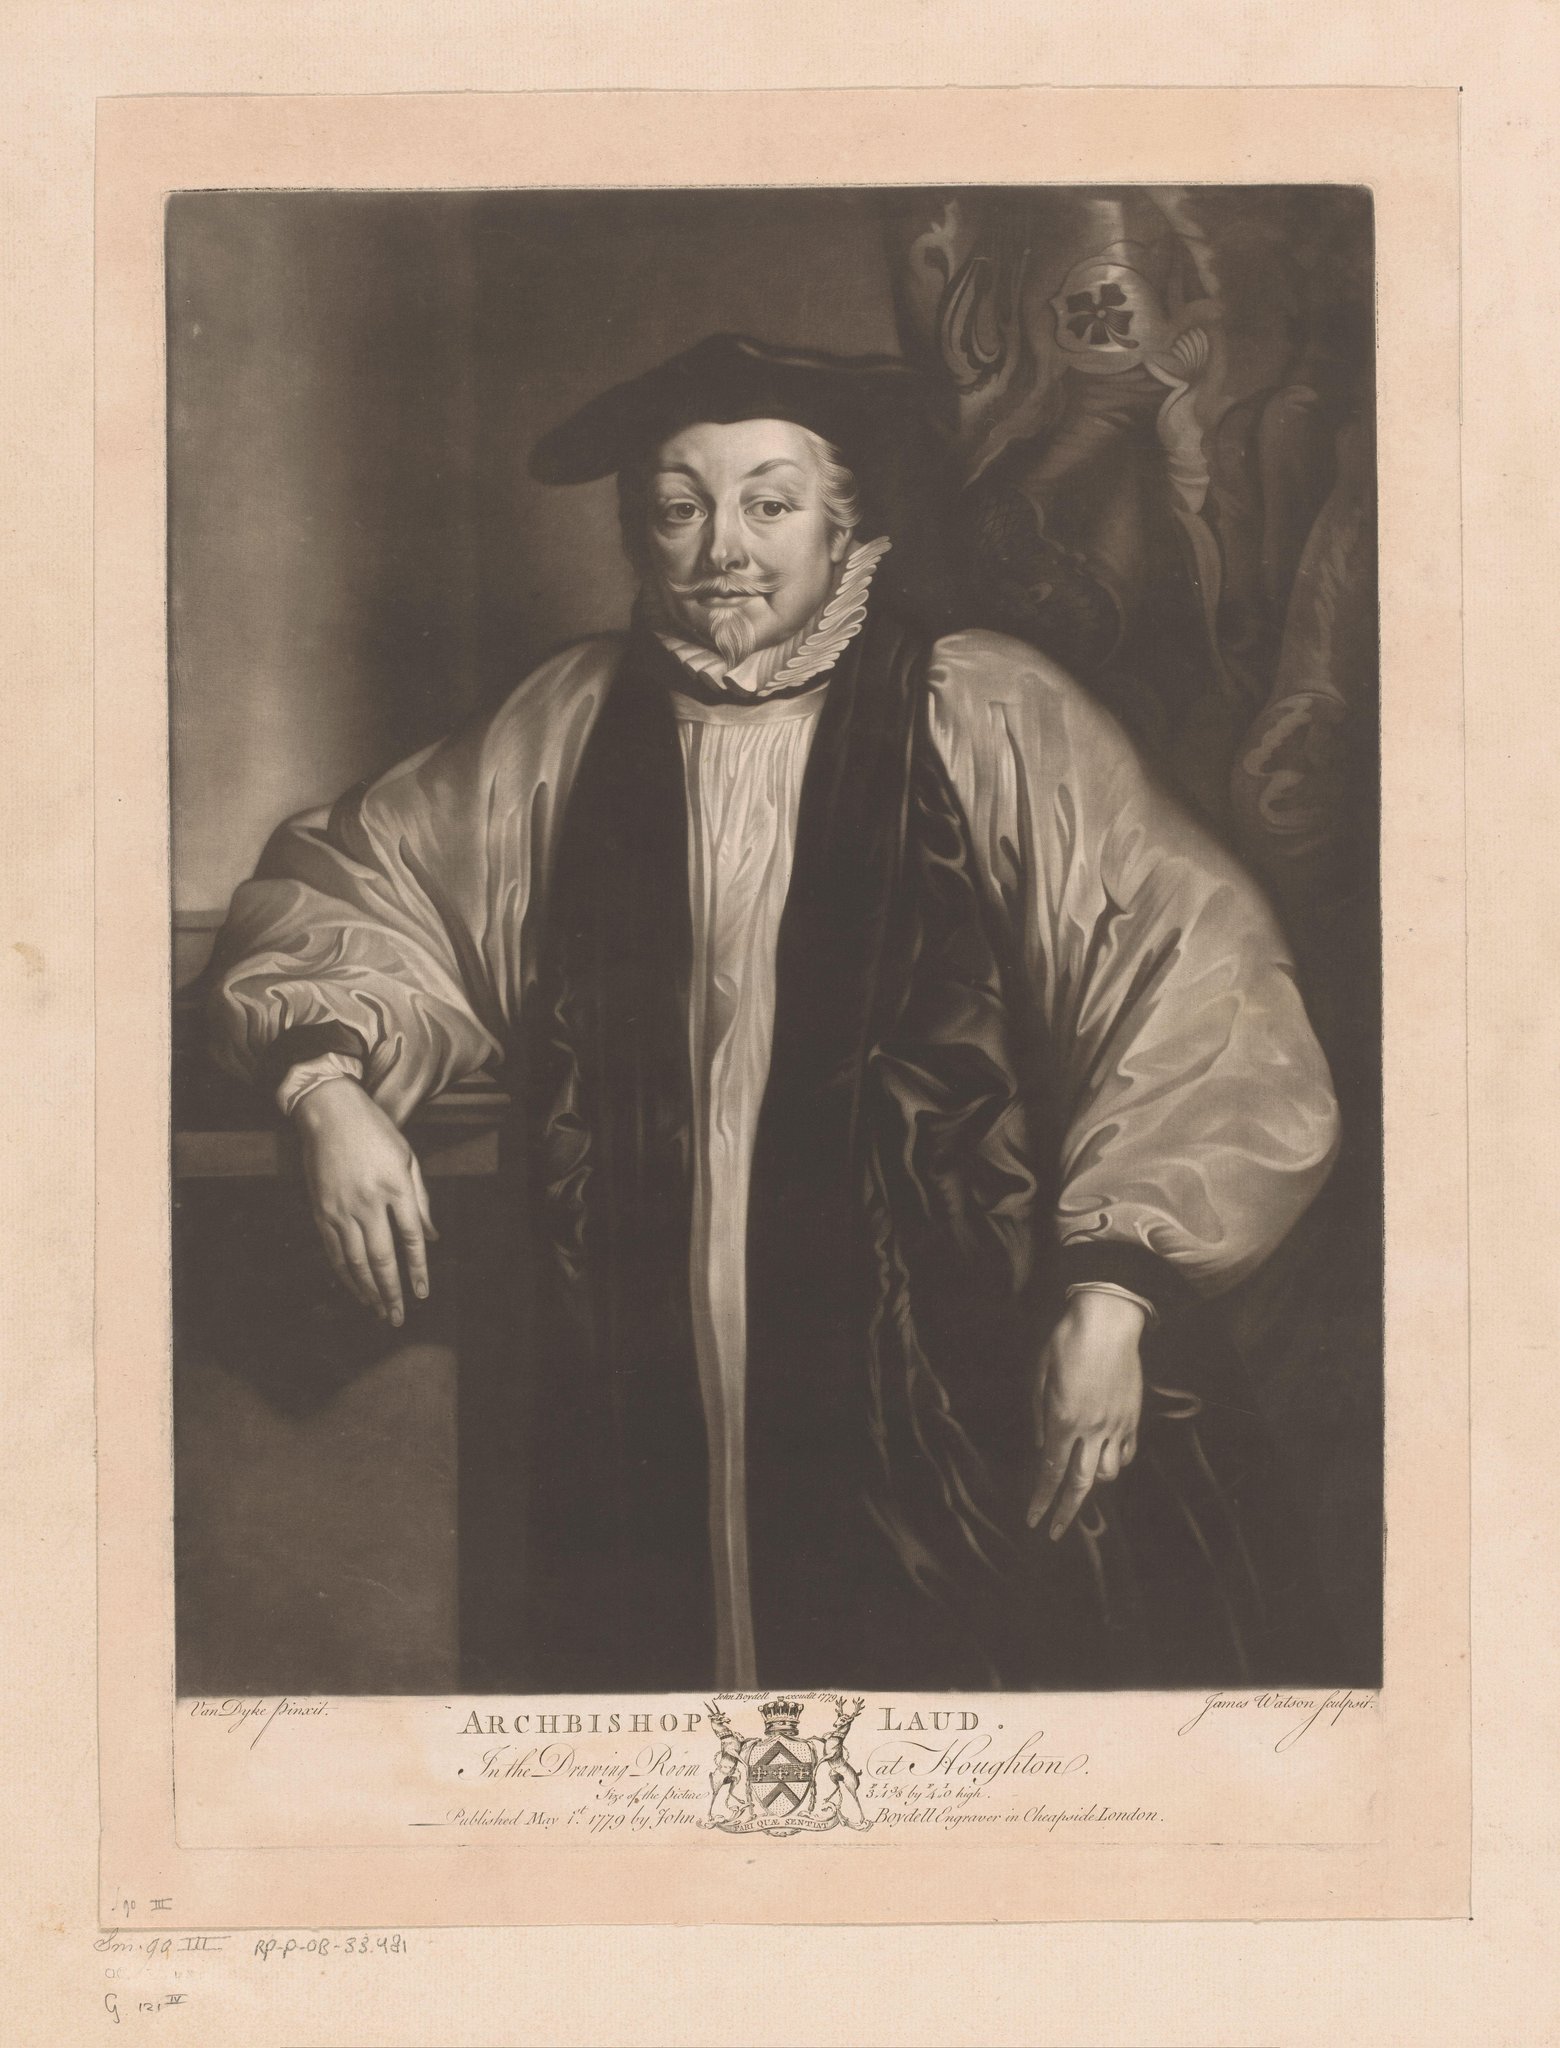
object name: print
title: Archbishop Laud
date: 1705-1779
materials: paper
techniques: mezzotint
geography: london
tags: clergyman, non-roman catholic episcopal churches, e.g. anglicans, historical persons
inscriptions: collector's mark: Lugt 2228